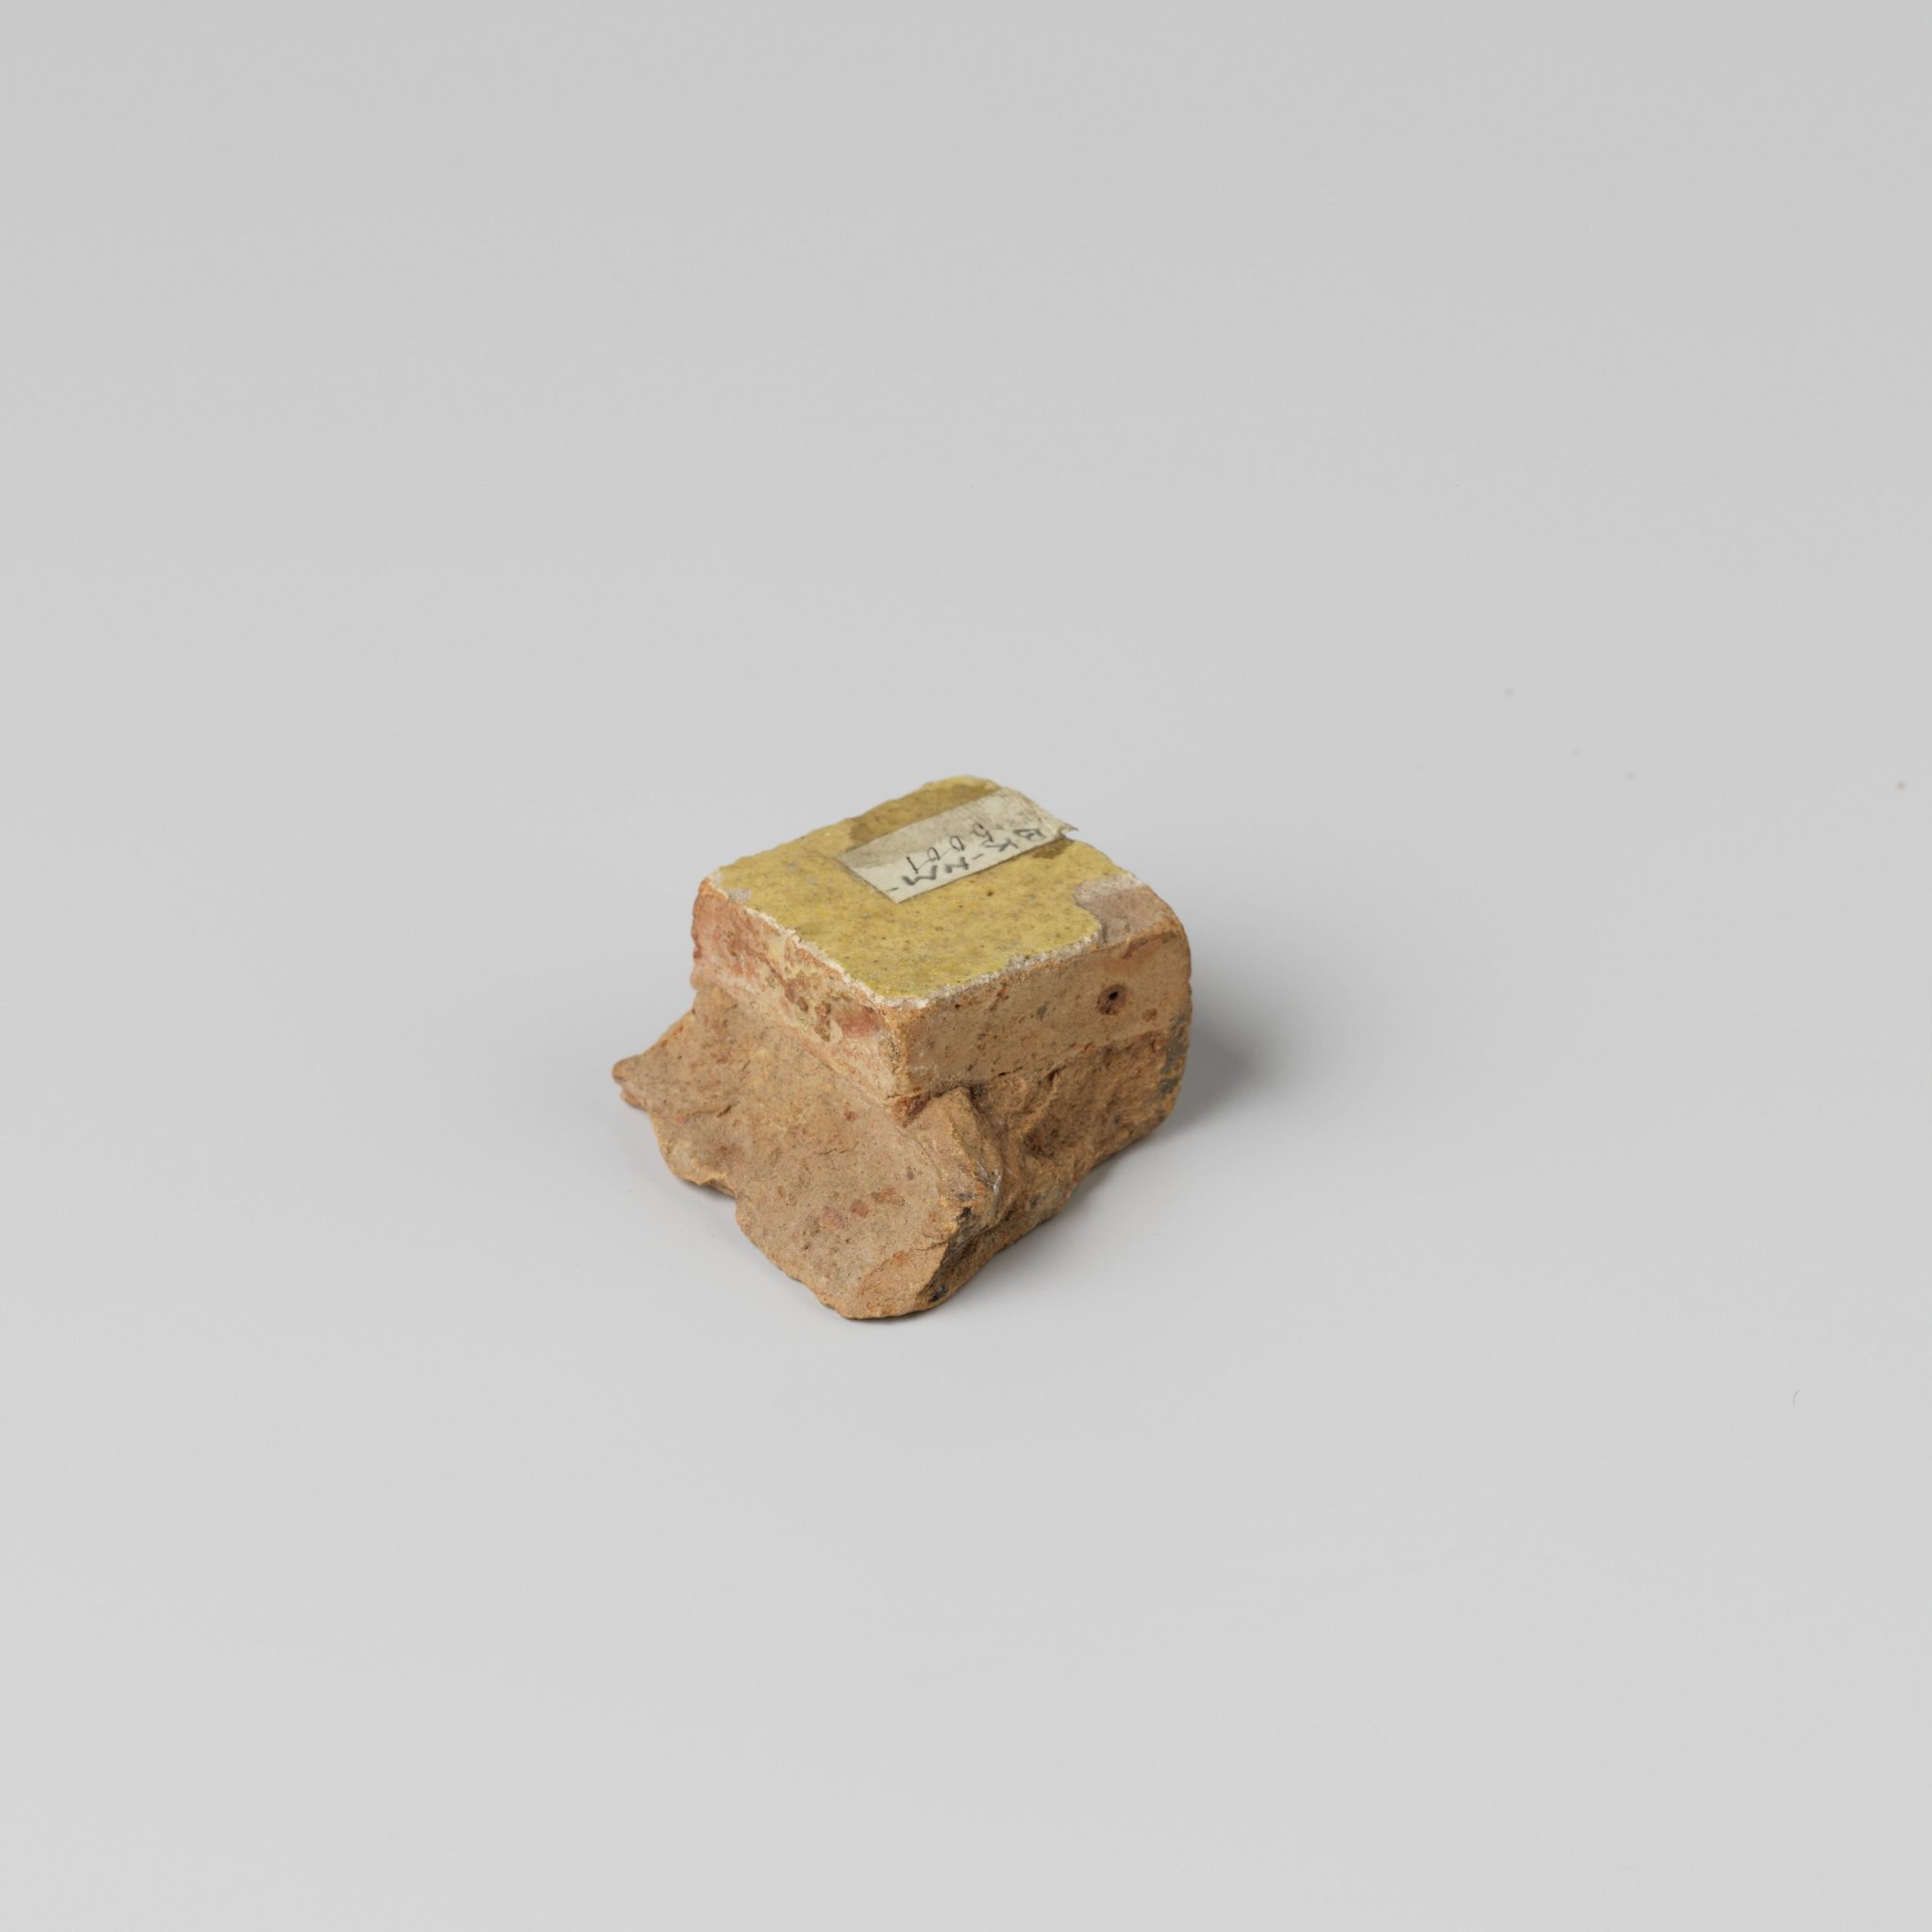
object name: tile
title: Tegel met geel glazuur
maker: Anonymous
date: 1600-1900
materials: earthenware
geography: netherlands